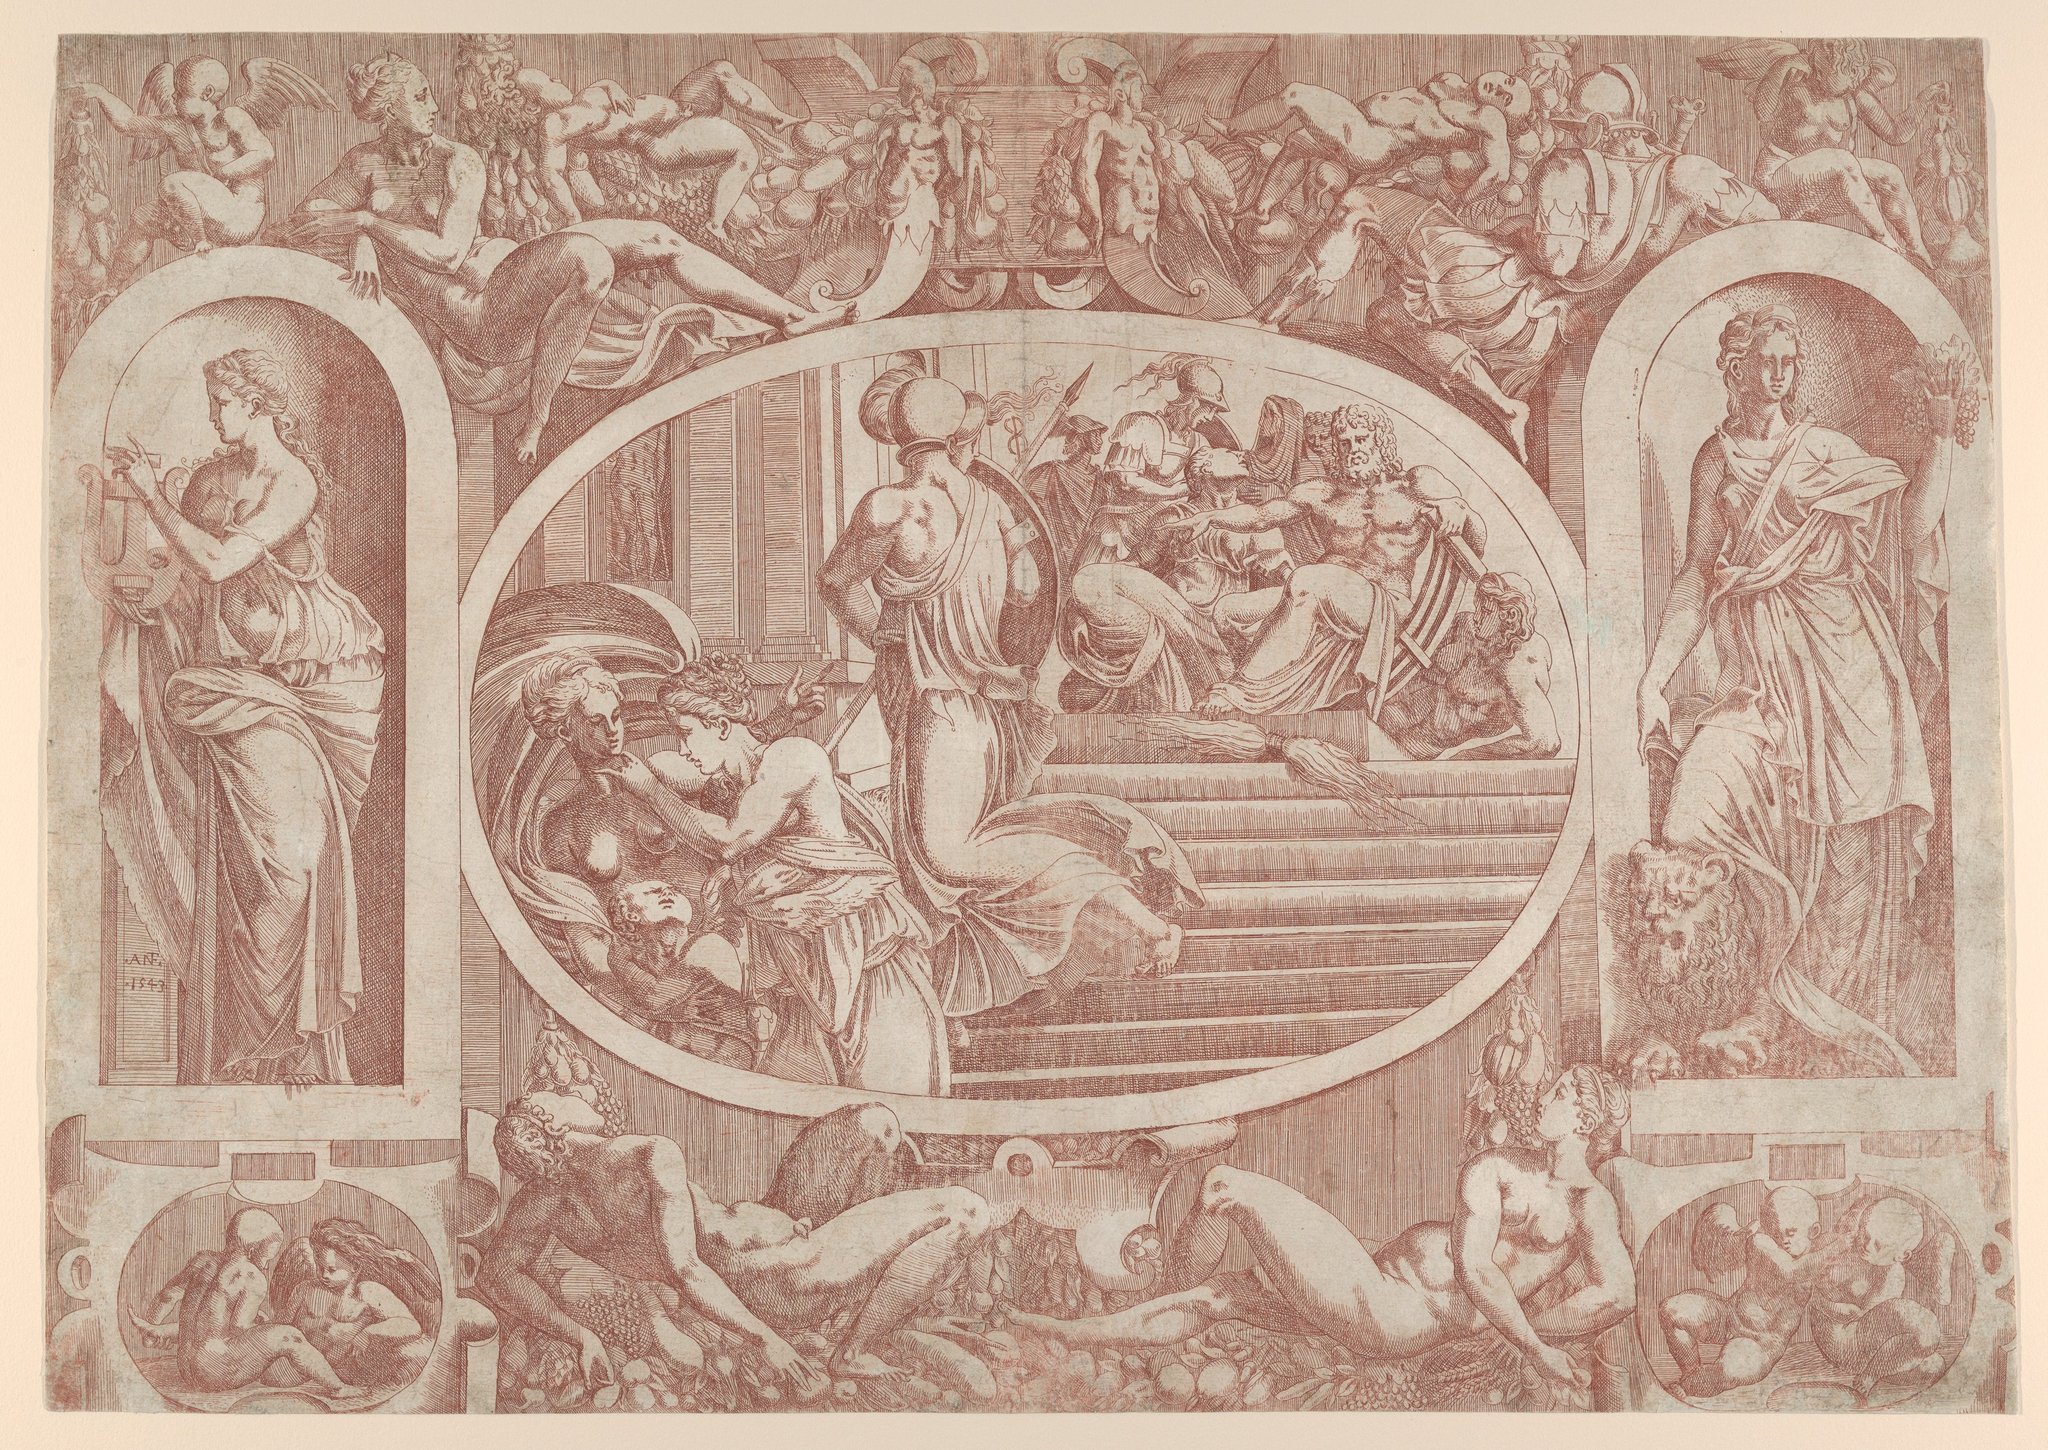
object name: print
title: Artemis, Athena and Aphrodite Leaving Olympus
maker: antonio fantuzzi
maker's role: artist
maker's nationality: italian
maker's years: 1537-1545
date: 1543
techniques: engraving, etching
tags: cupid,jupiter,goddess